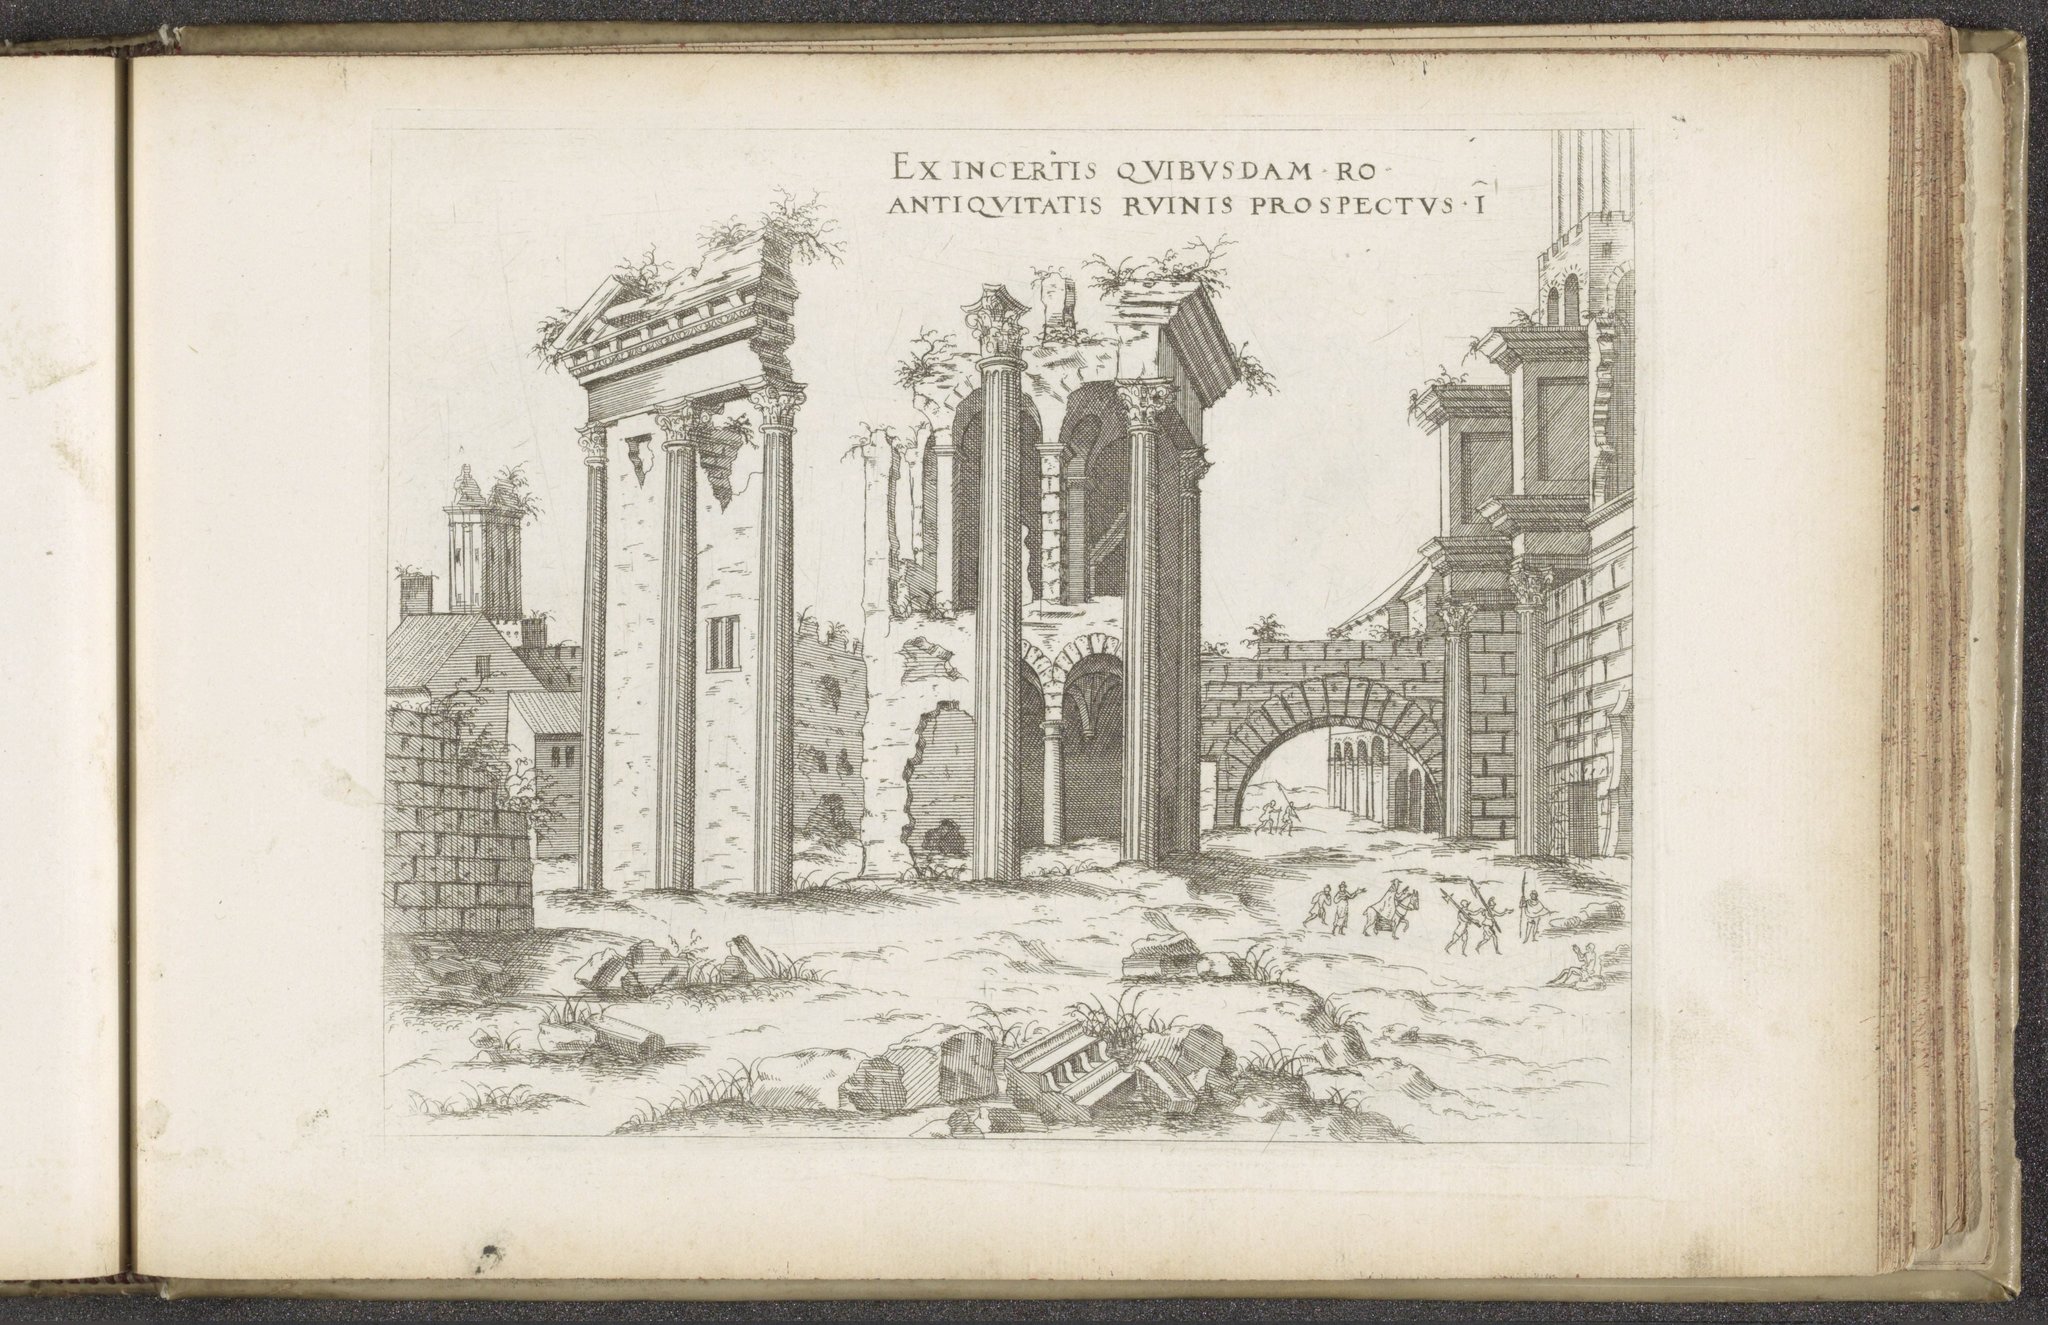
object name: album leaf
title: Praecipva Aliqvot Romanae Antiqvitatis Rvinarum Monimenta Vivis Prospectibus Ad Veri Imitationem Affabre Designata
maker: jacques androuet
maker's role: draughtsman, print maker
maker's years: 1515-1584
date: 1551-1584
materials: paper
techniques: etching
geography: france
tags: ruin of a building ~ architecture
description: Gezicht op de ruïnes van het Forum Nerva in Rome. Een groepje soldaten loopt tussen de gebouwen rond. Deze prent maakt deel uit van een album.